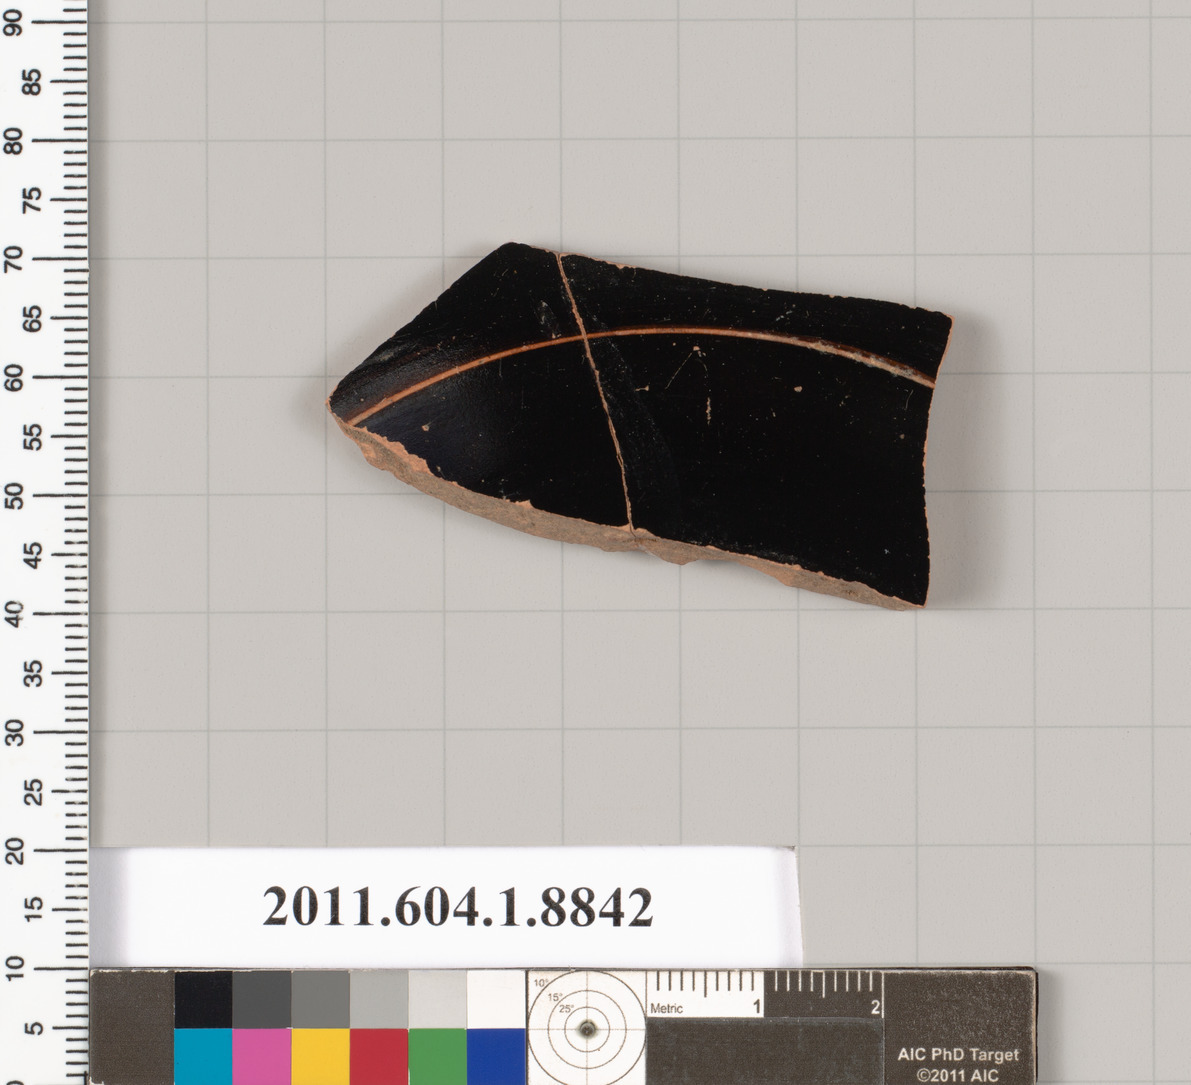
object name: kylix fragment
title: Terracotta fragment of a kylix (drinking cup)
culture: greek, attic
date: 500-470 BCE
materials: terracotta